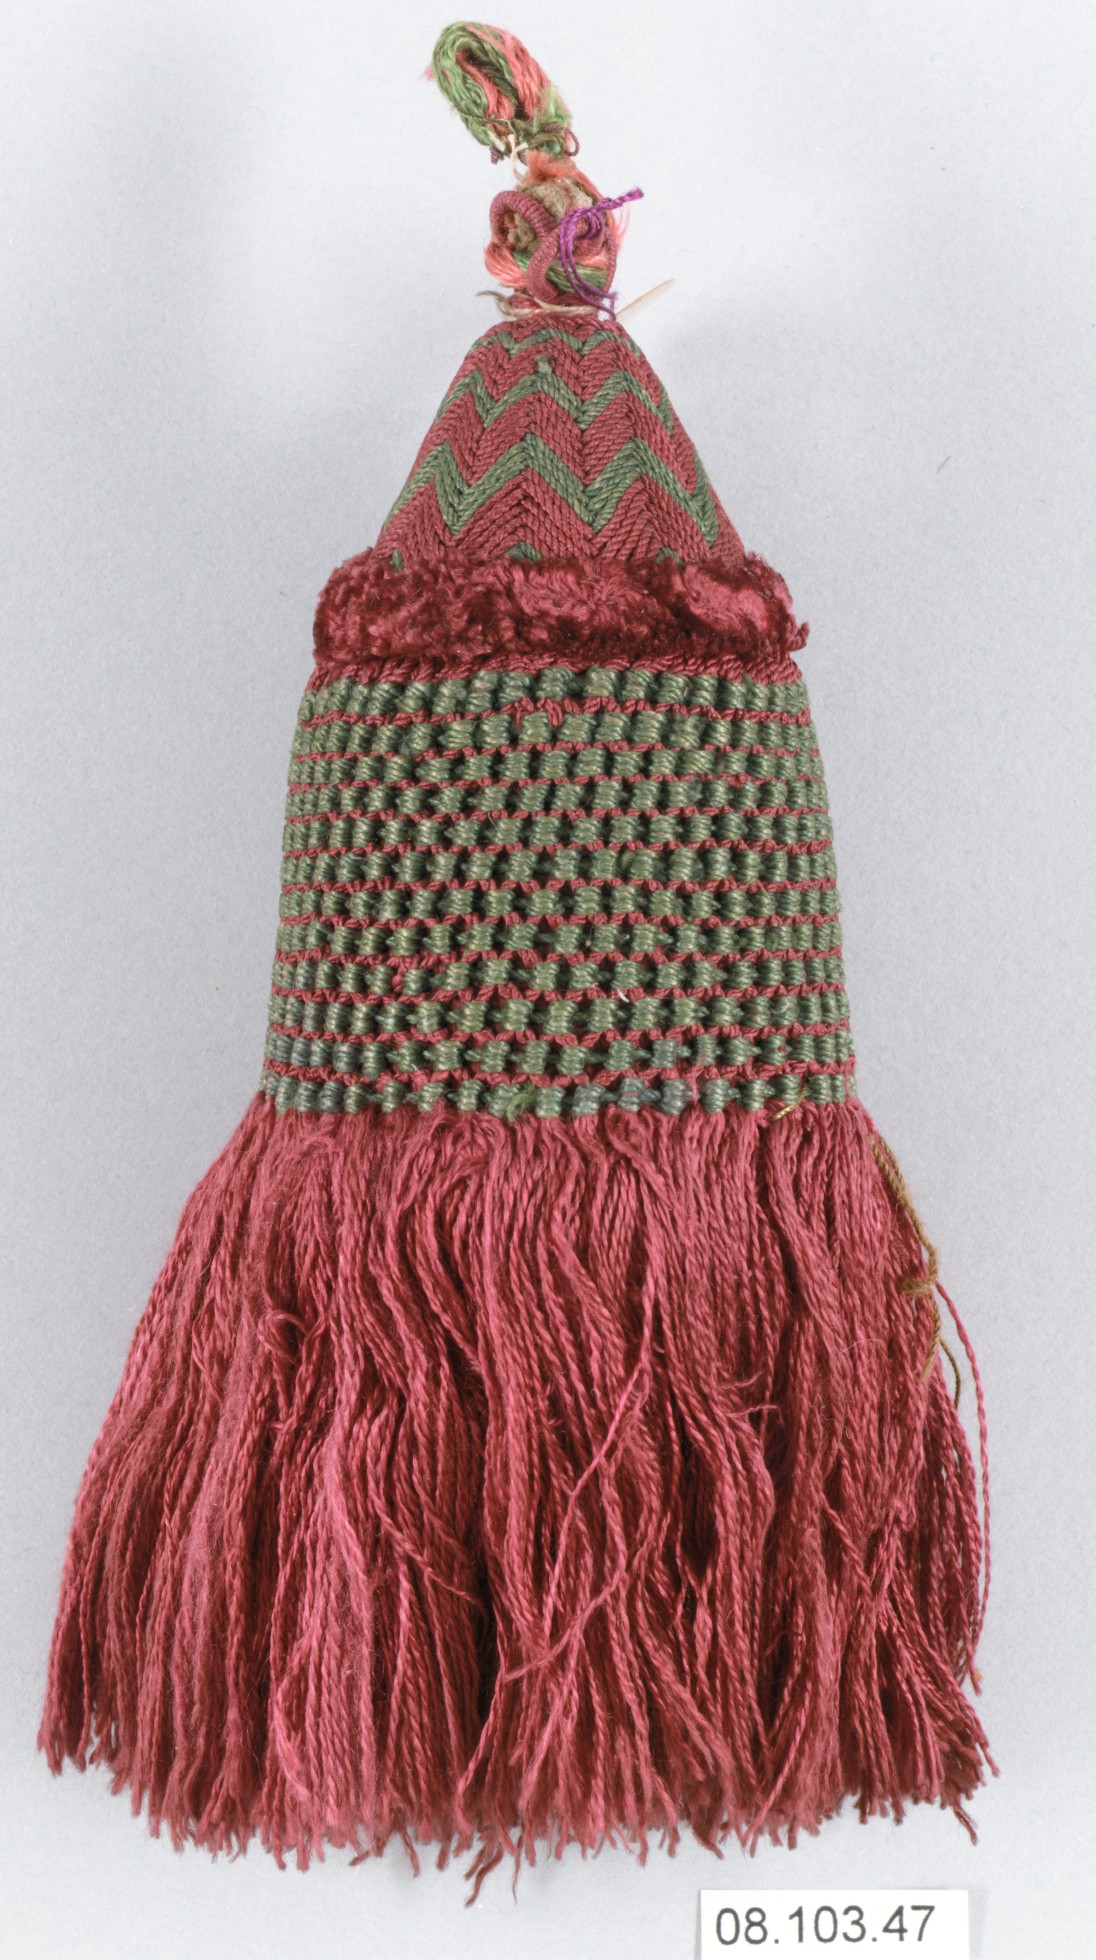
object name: tassel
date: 1567-1633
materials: silk